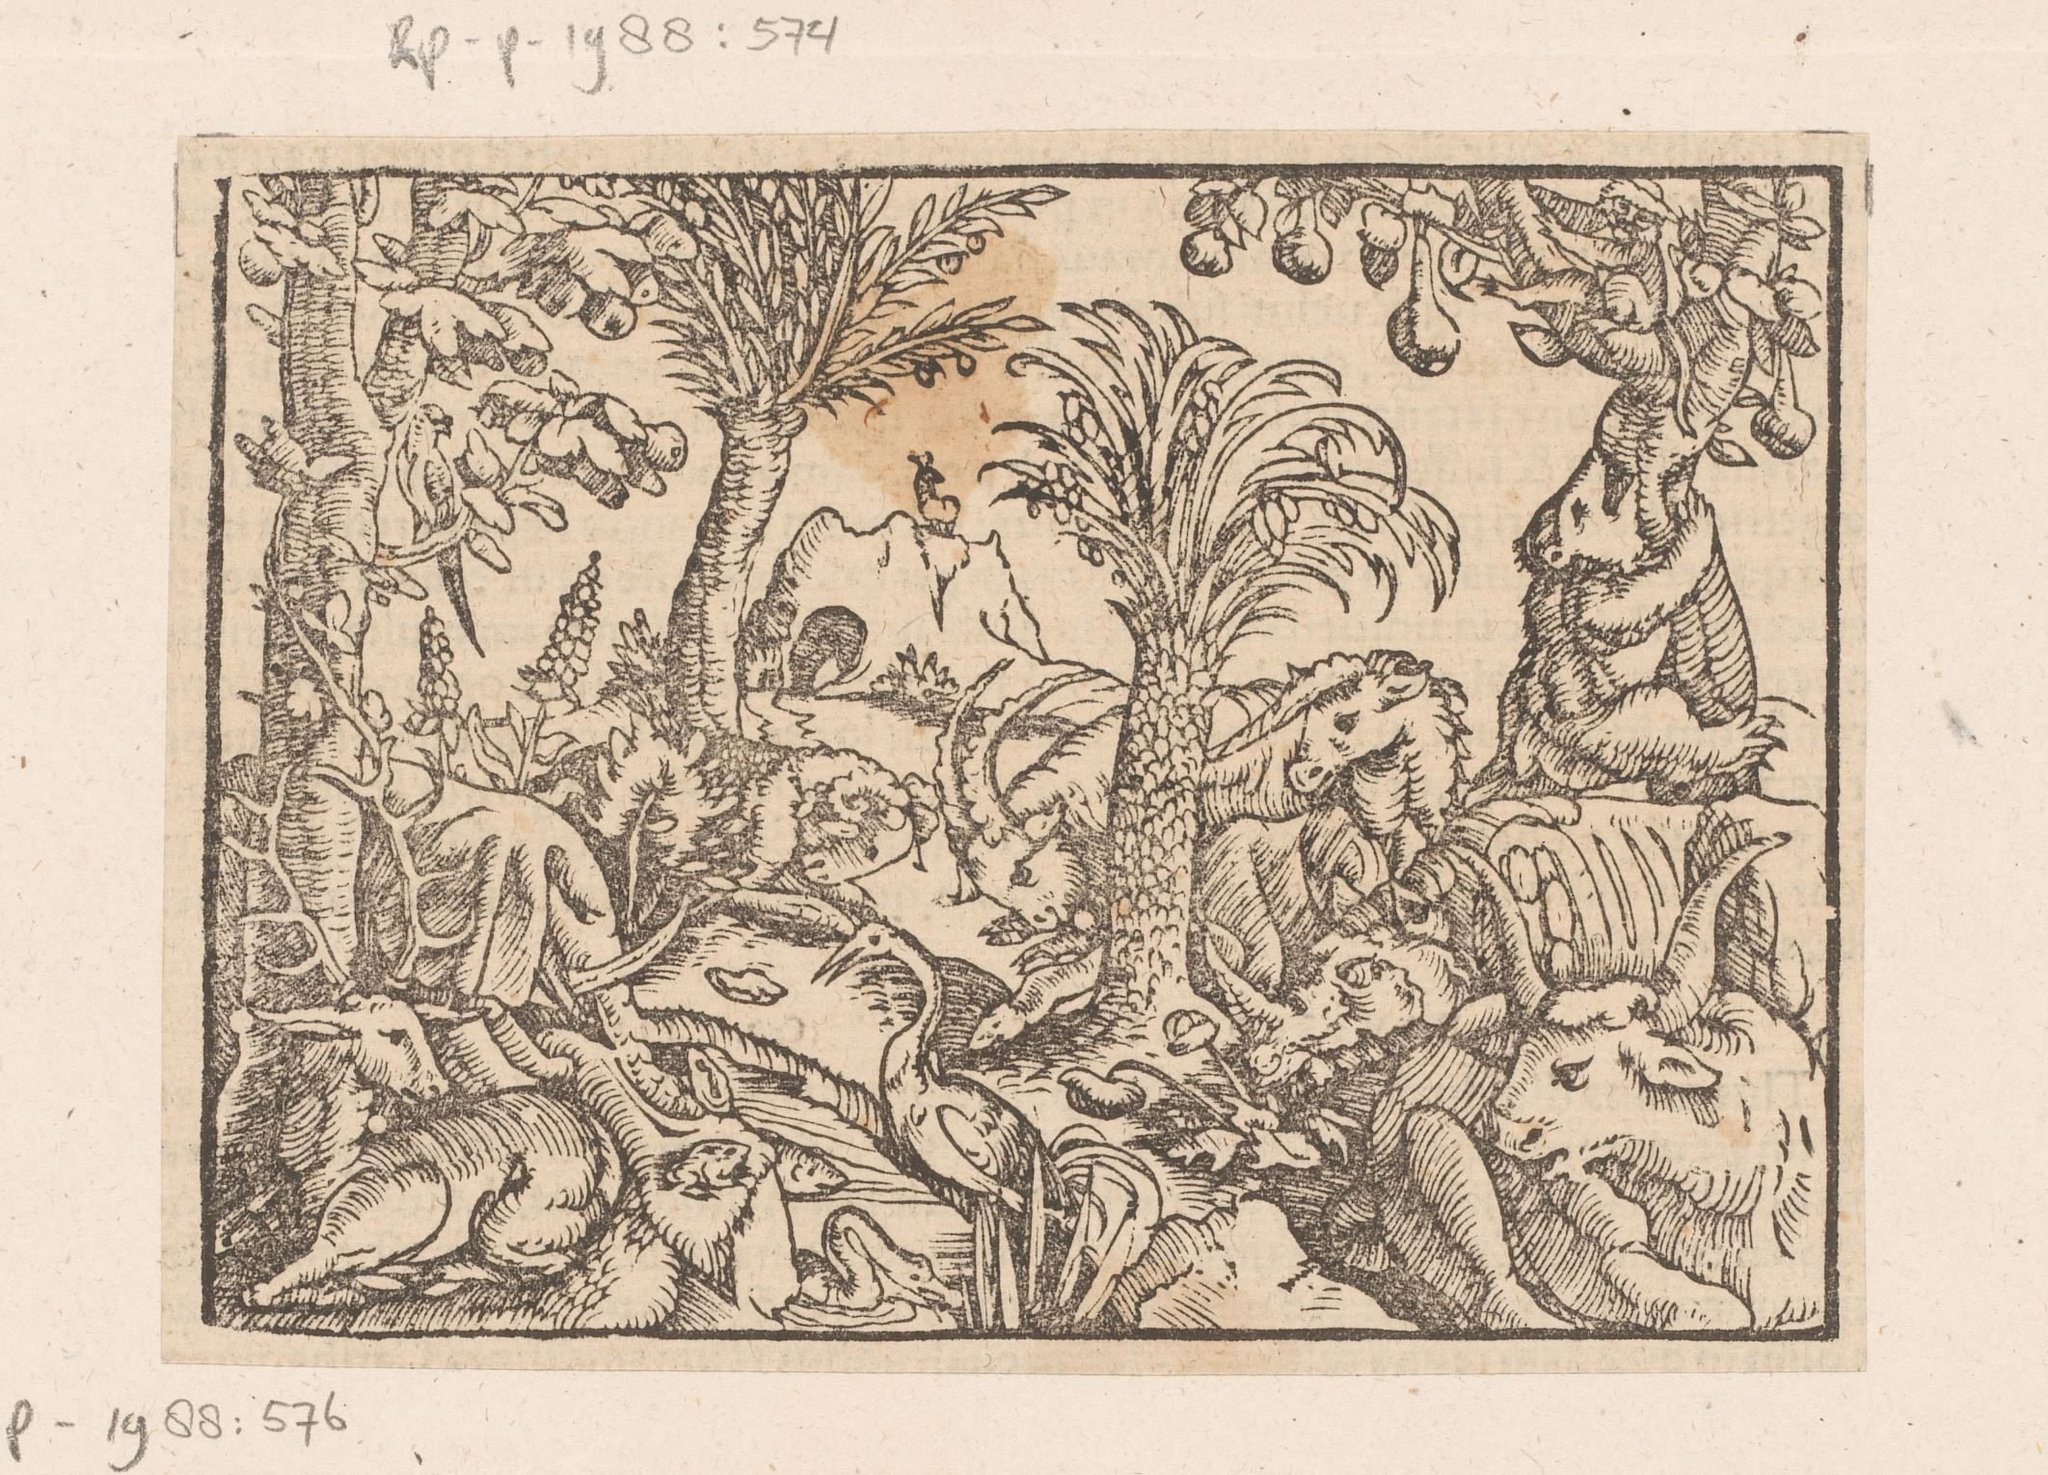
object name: print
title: Verschillende dieren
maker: Anonymous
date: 1500-1599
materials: paper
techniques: woodcut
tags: heaven, celestial paradise, new earth, fabulous animals (sometimes wrongly called 'grotesques'); 'mostri' (ripa), animals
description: Prent afkomstig uit een onbekende publicatie.